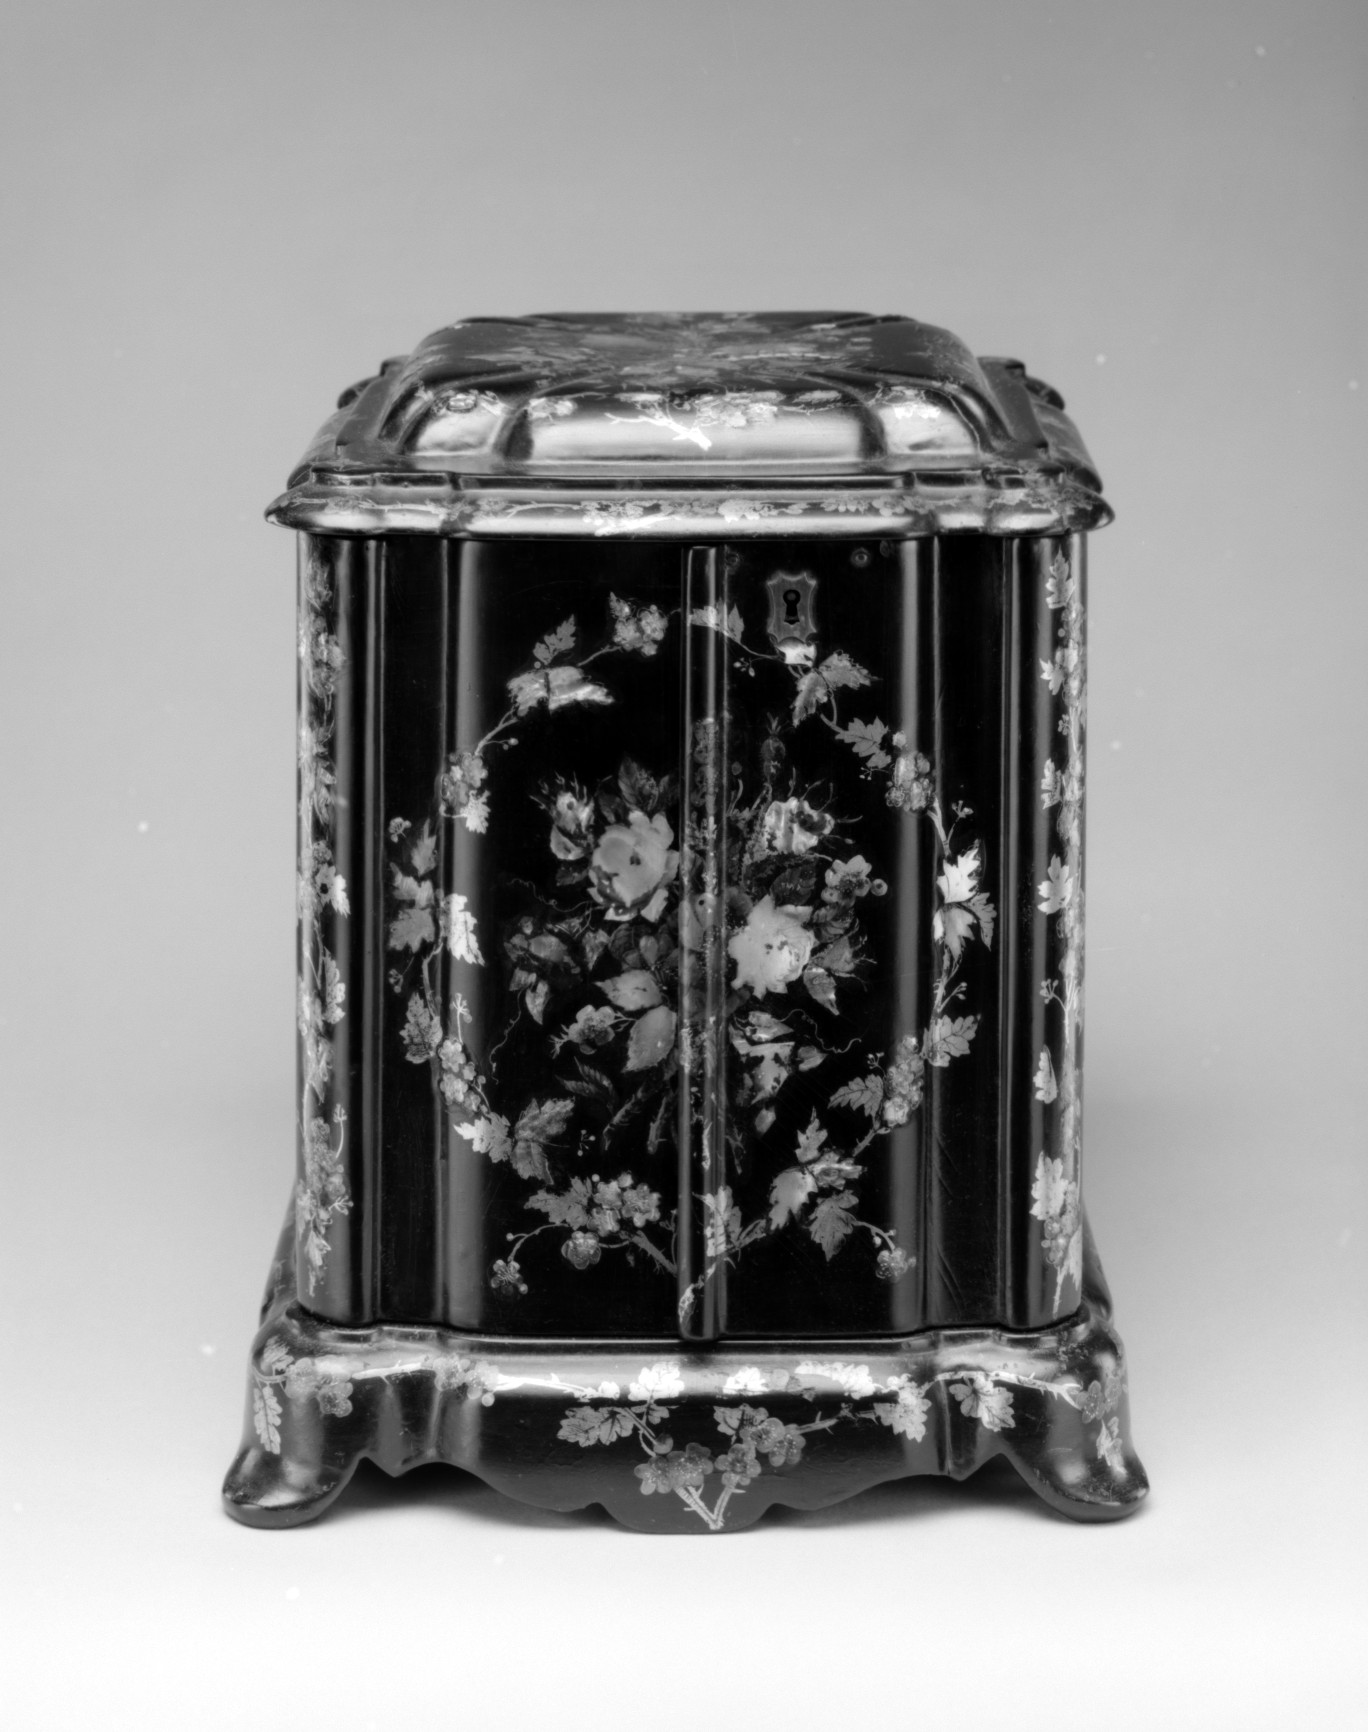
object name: work and jewelry cabinet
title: Small work and jewelry cabinet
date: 1834-1866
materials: mother of pearl, paper, silk, velvet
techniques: gilding, lacquer, painting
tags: flowers